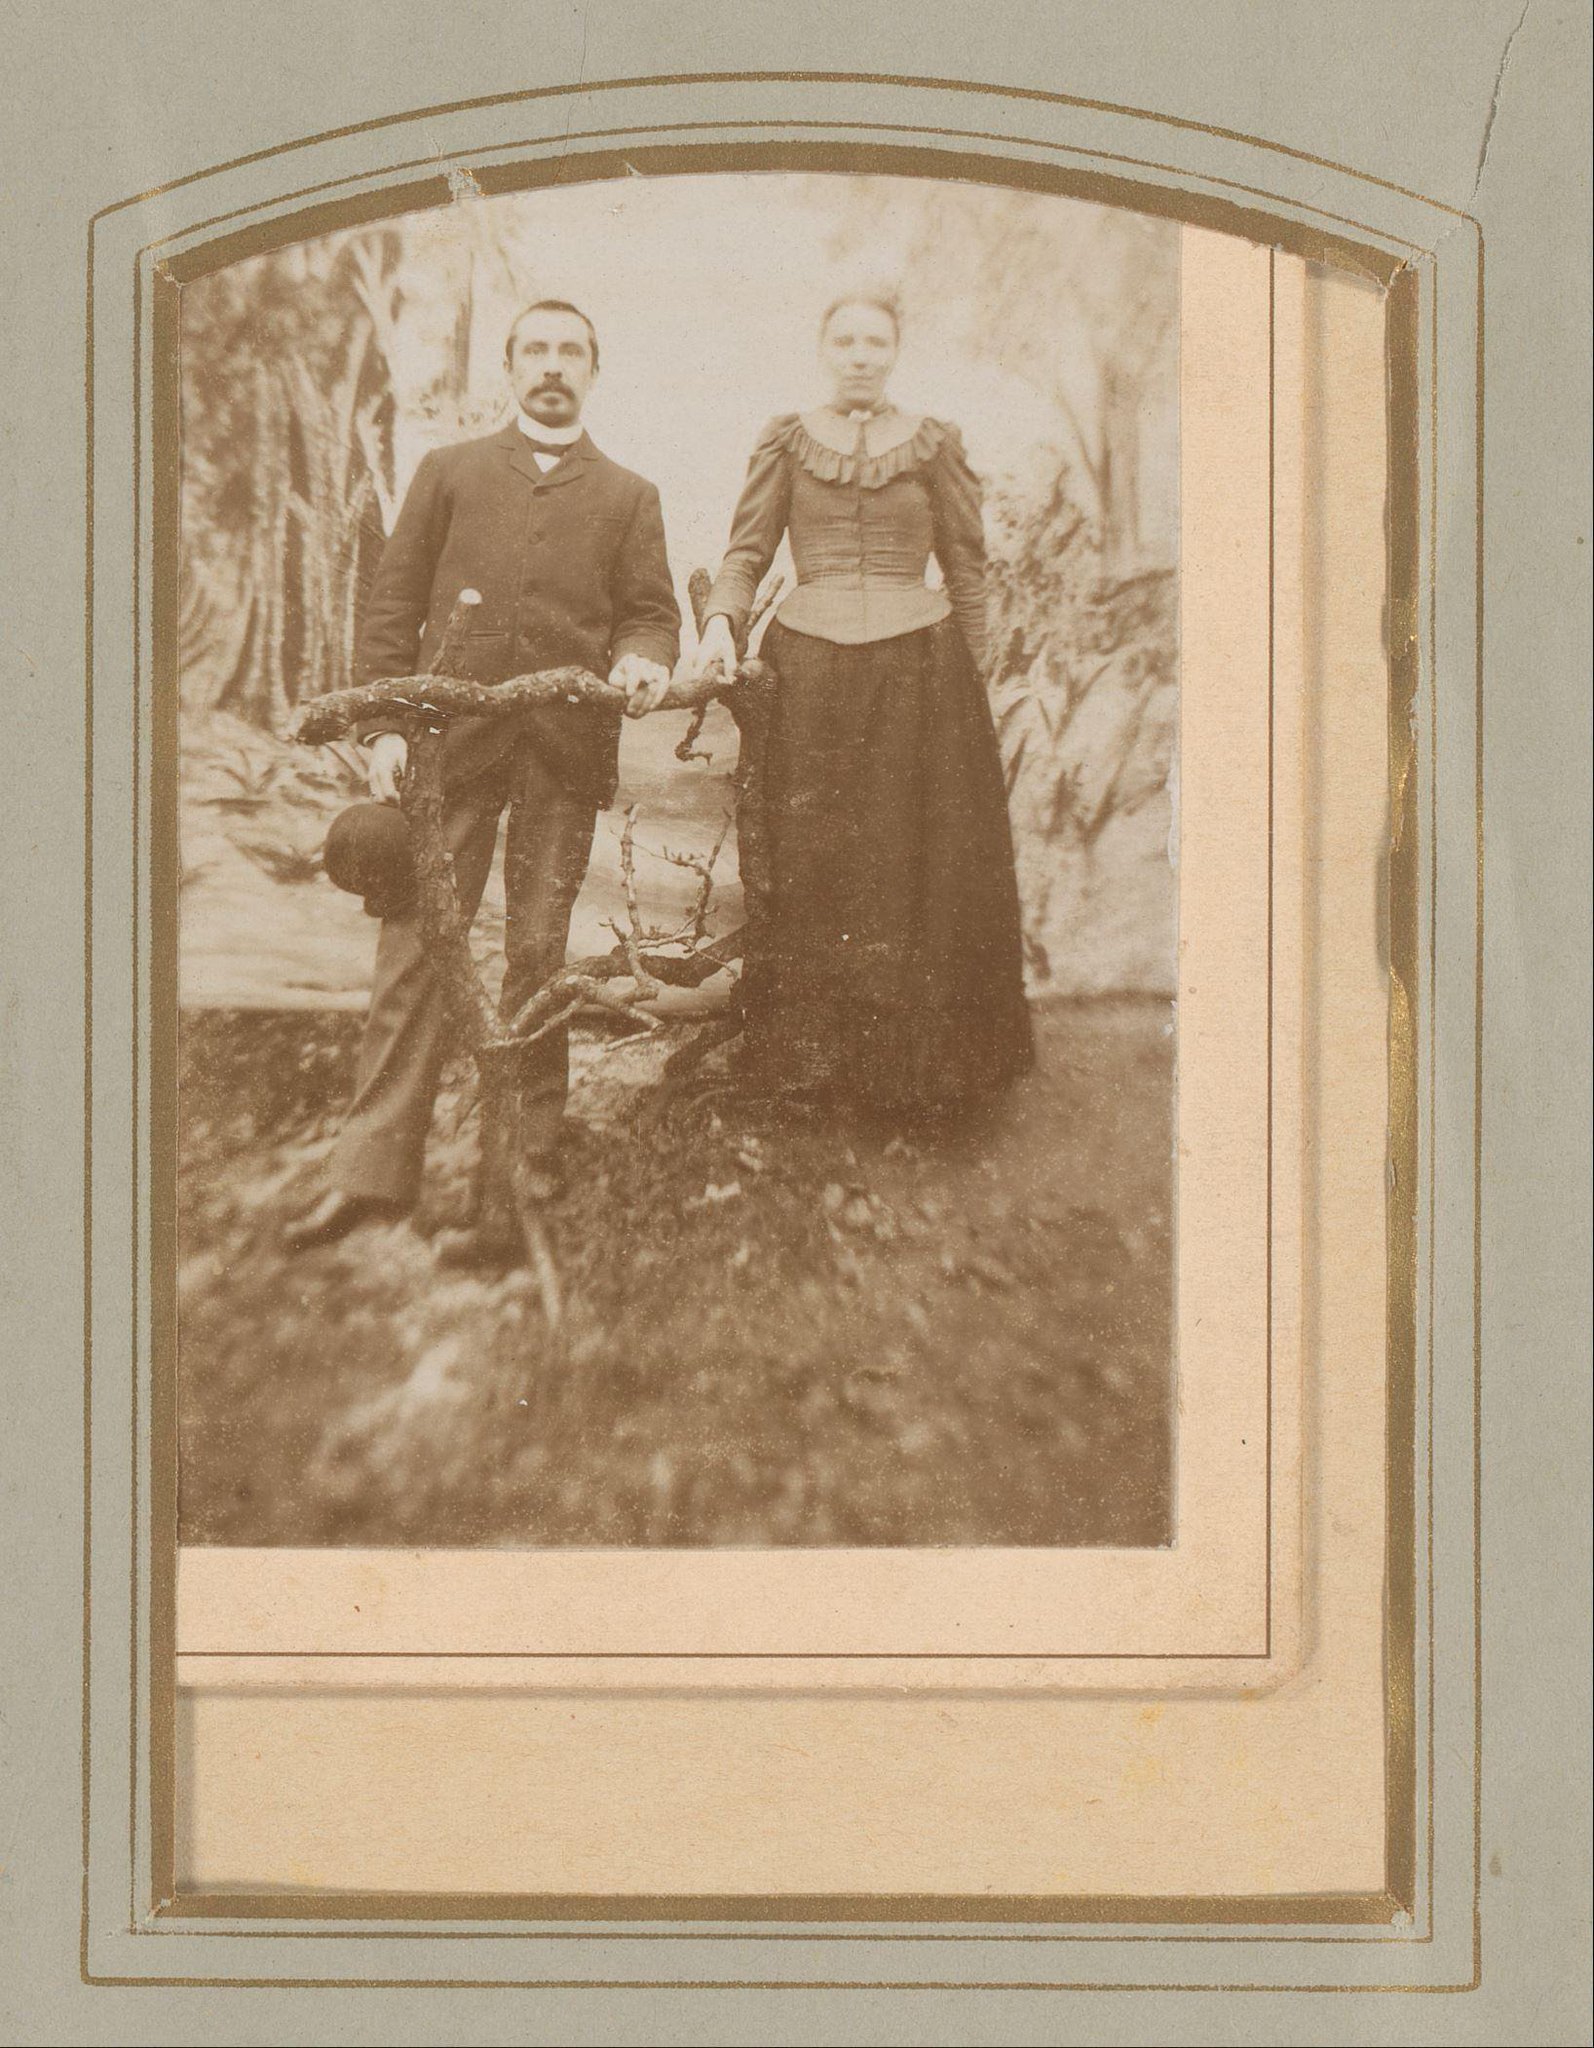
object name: photograph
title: Portret van een man en een vrouw bij een hek van takken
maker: Anonymous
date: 1880-1920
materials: cardboard, photographic support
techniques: collodion silver print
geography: netherlands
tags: historical persons - bb - woman, fence, wall, paling, historical persons